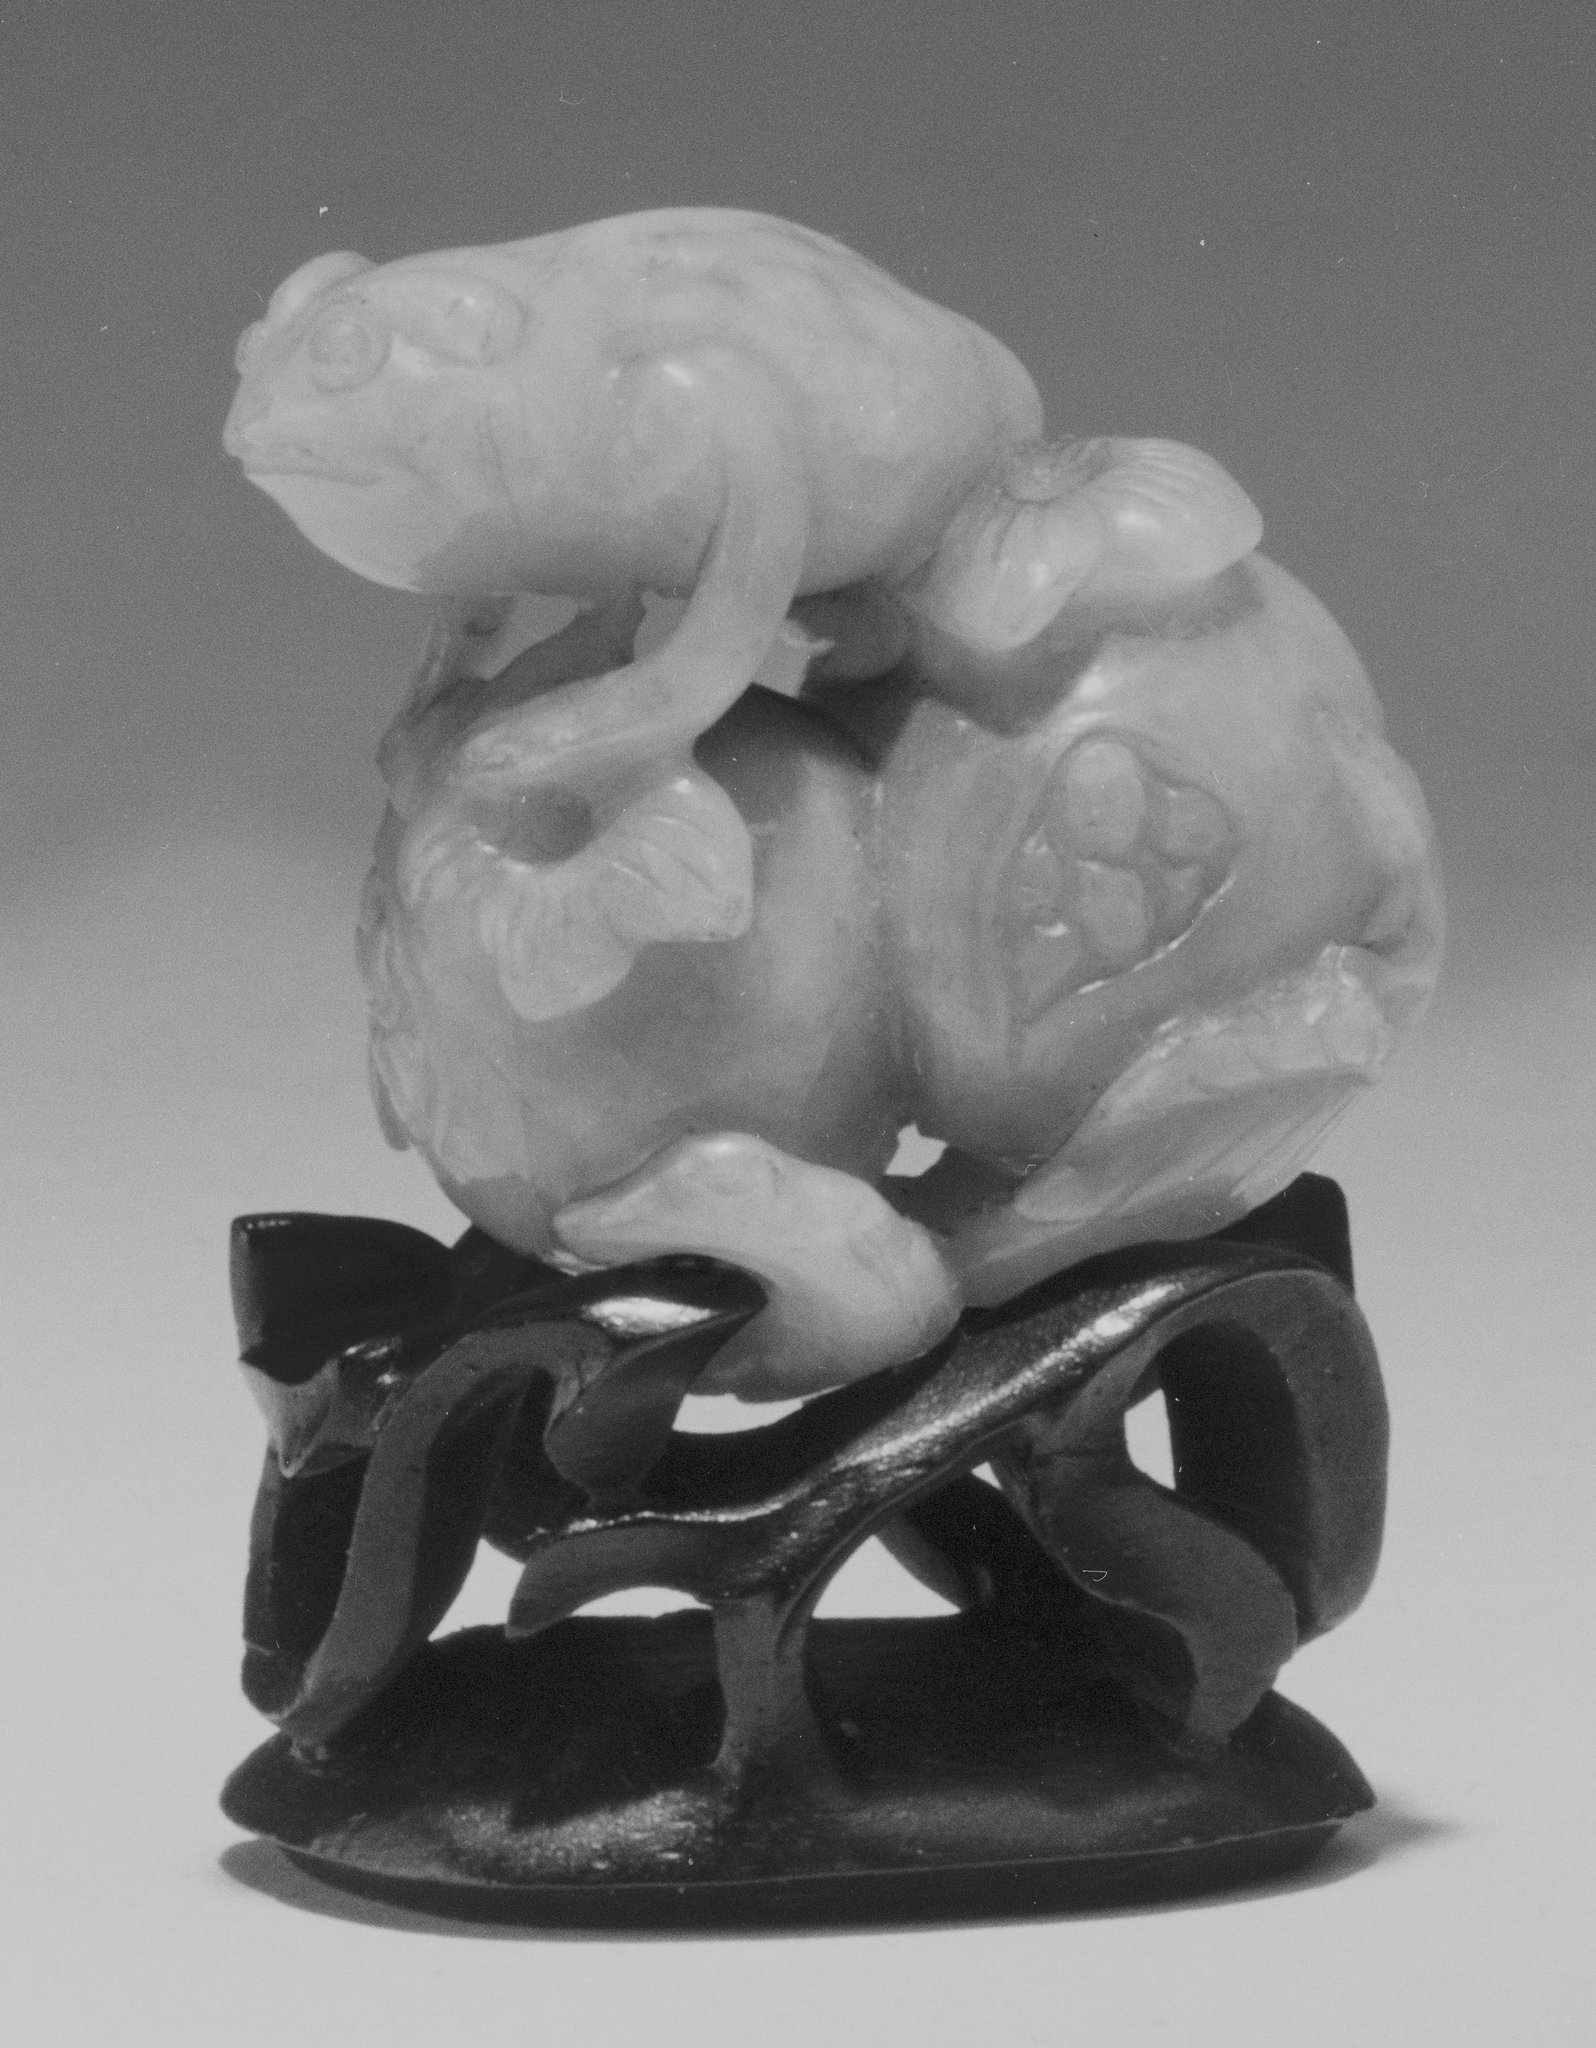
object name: figurine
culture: chinese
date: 1736-1795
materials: jade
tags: frogs